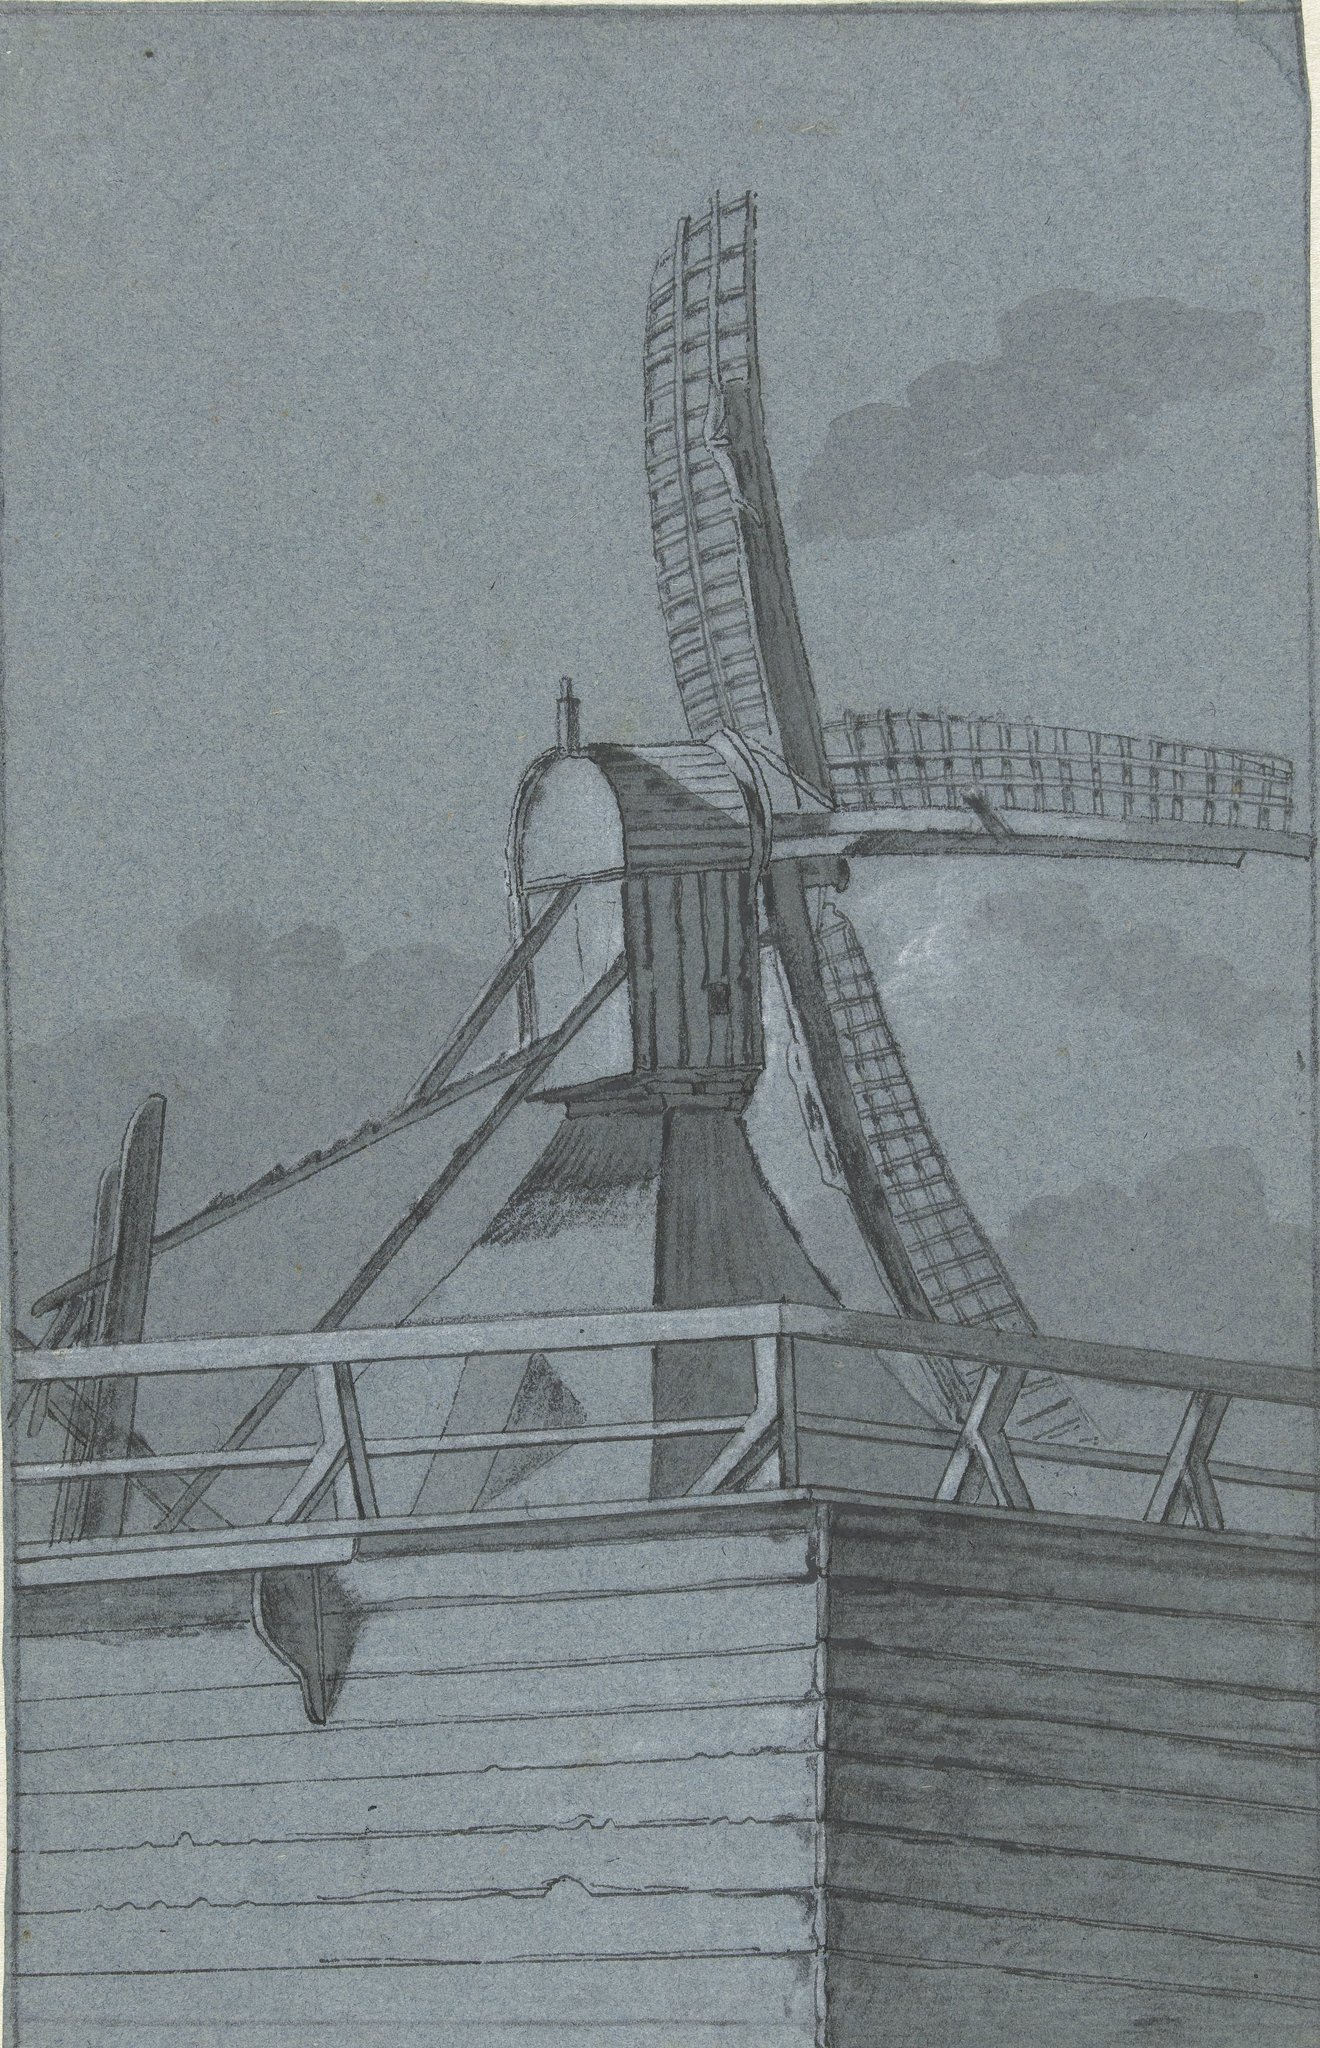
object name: drawing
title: Windmolen met houten onderbouw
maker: jacob ernst marcus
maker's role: draughtsman, print maker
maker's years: 1774-1826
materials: chalk, ink, paper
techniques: brush, pen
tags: windmill